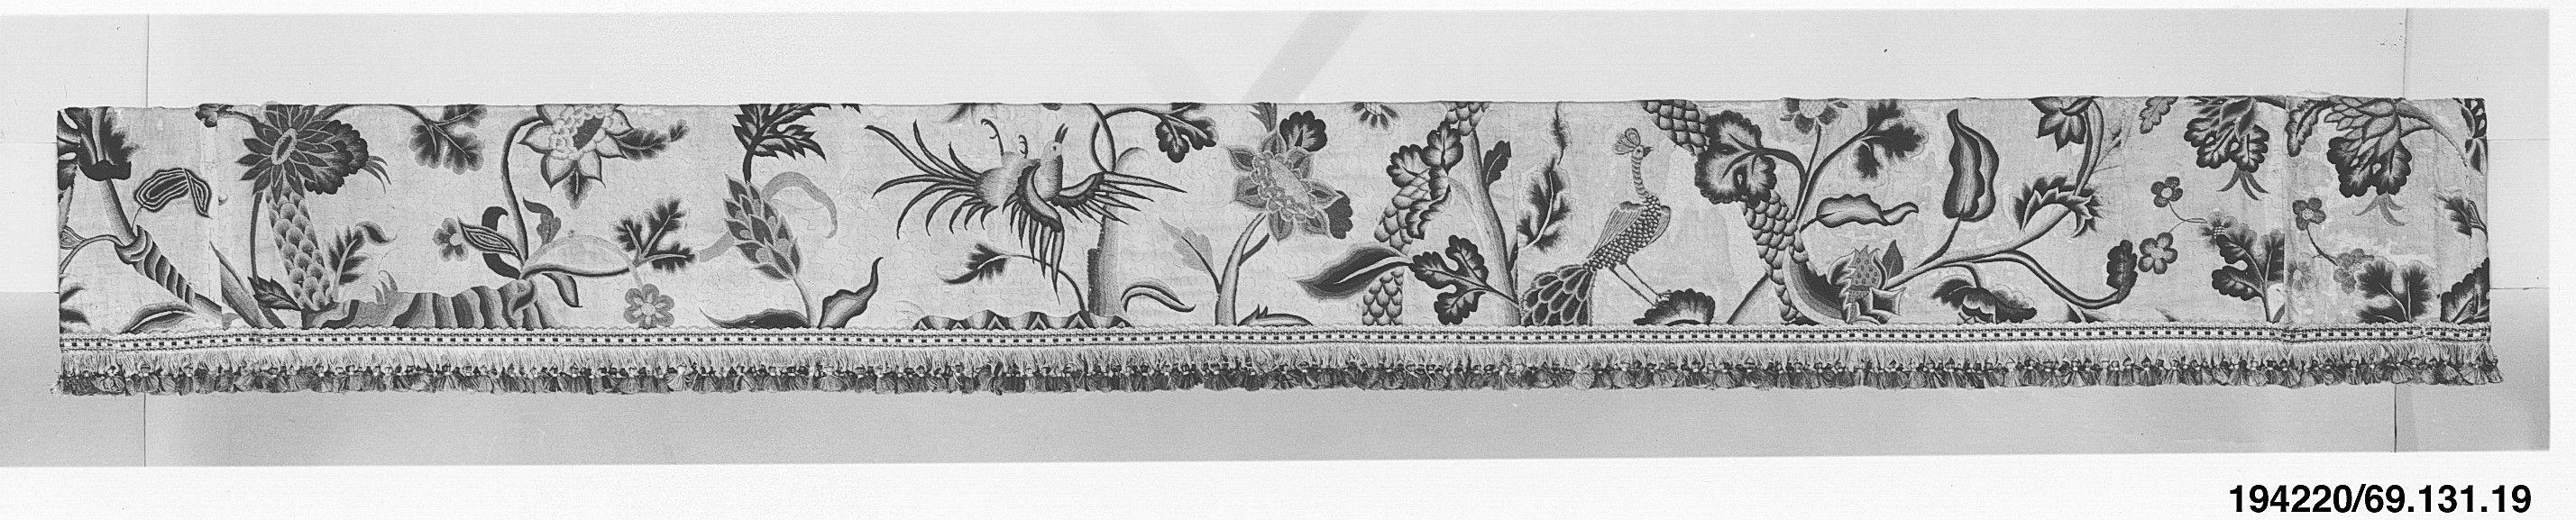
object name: valance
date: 1701-1750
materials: linen, silk, wool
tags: flowers